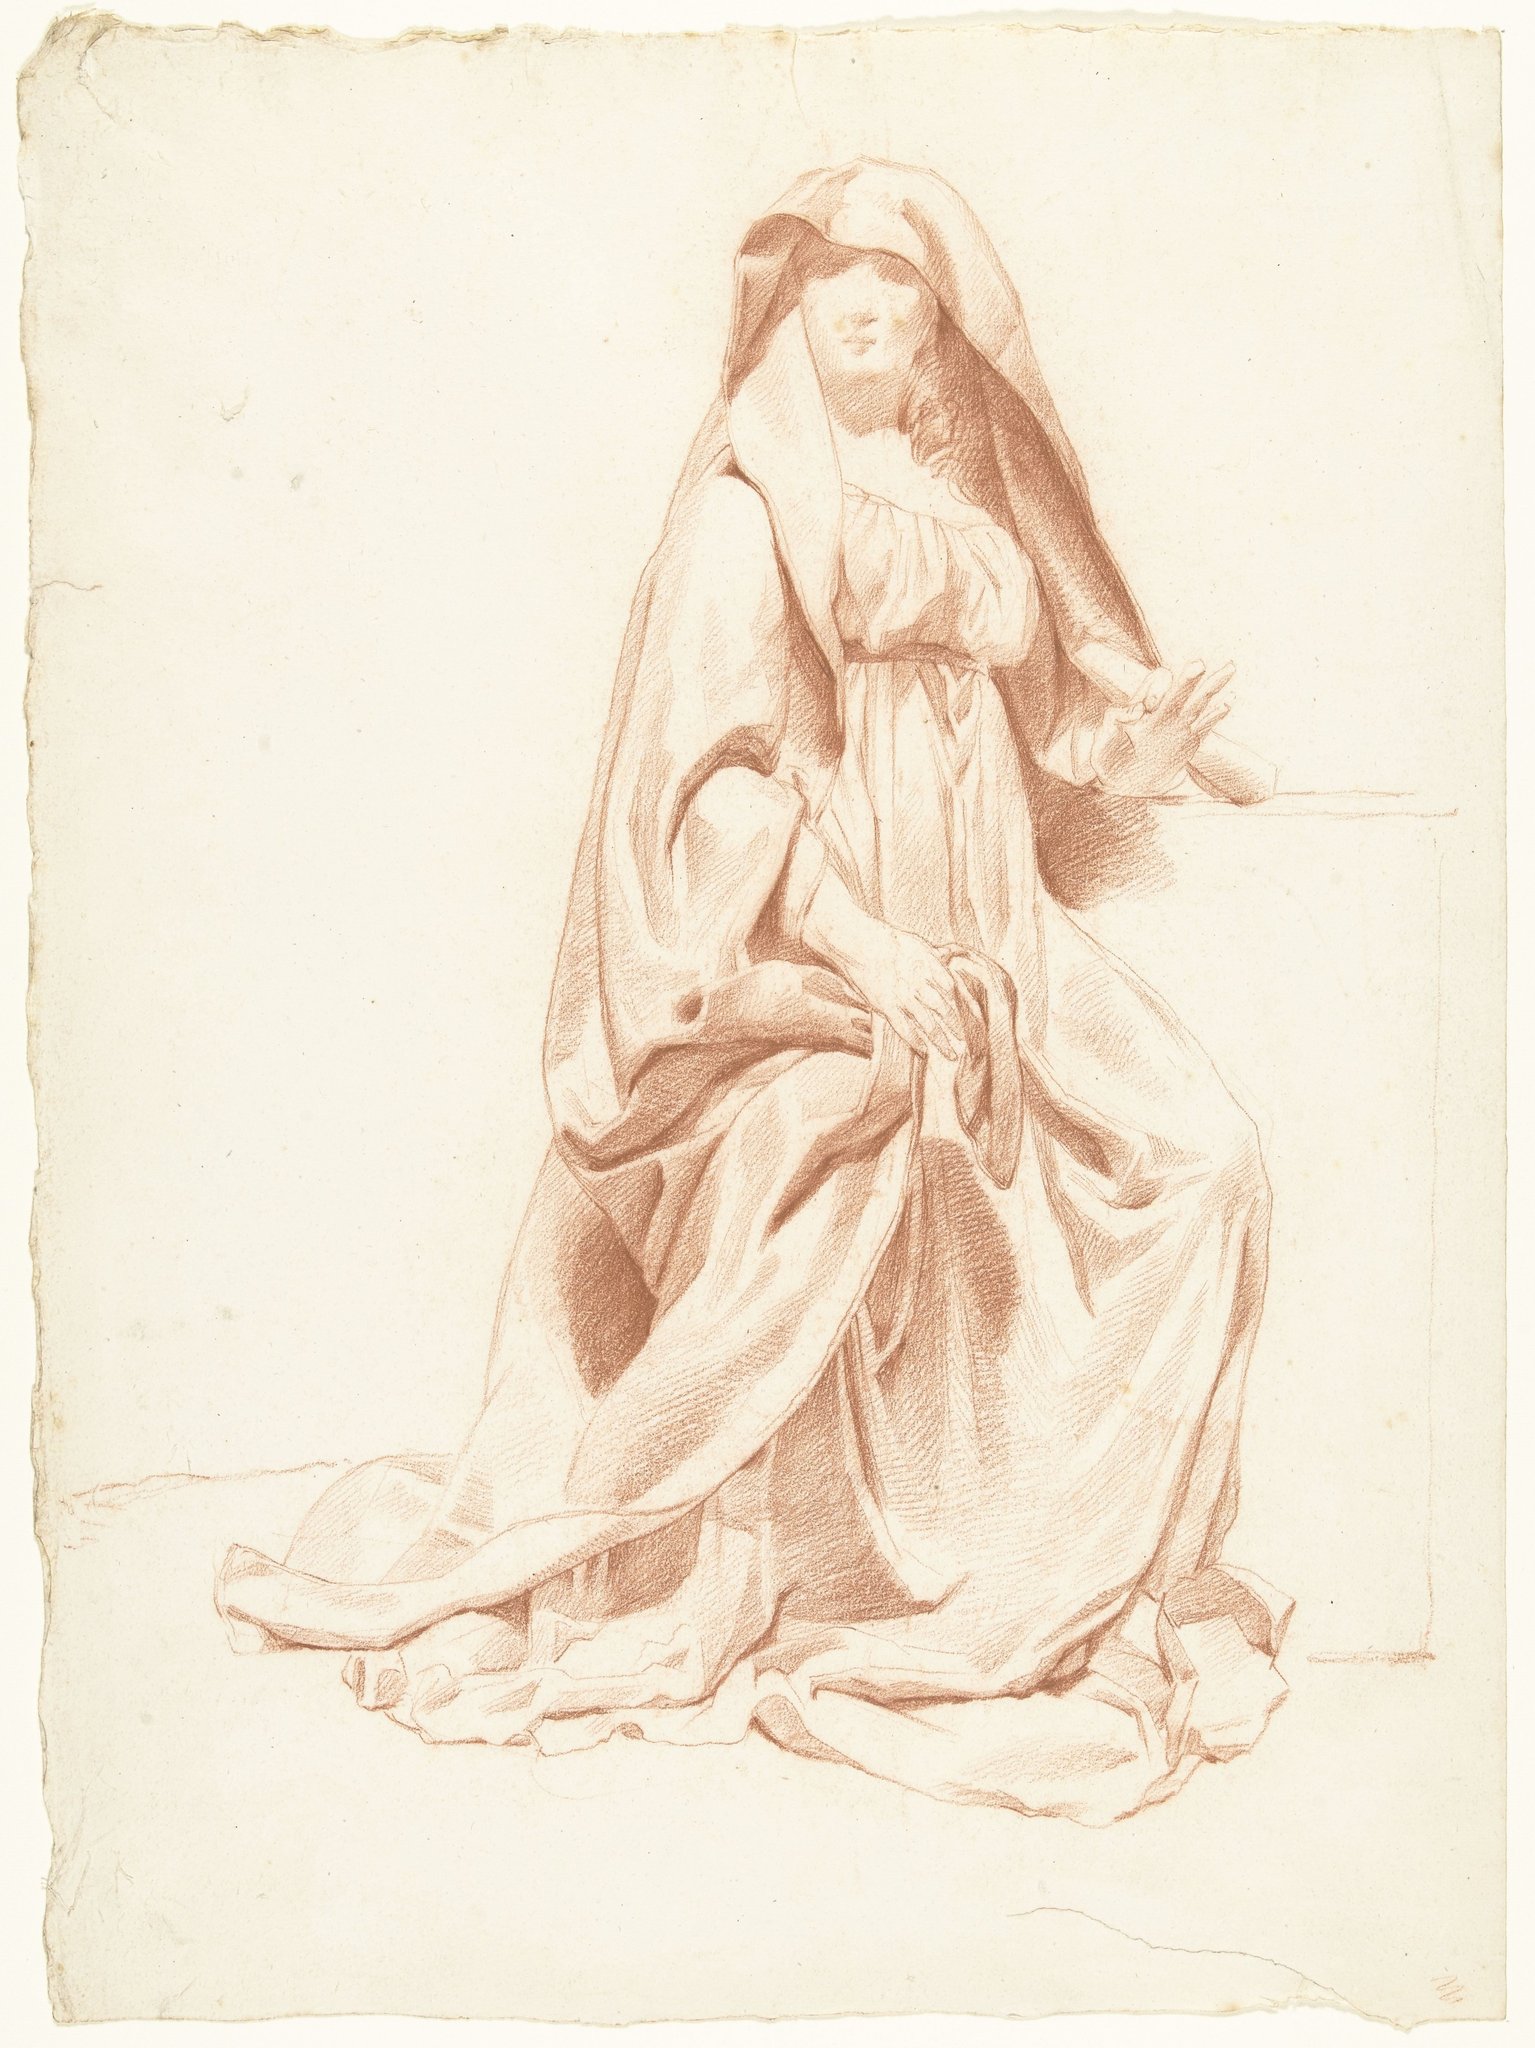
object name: drawing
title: Studie van een zittende vrouw met zwaar geplooide mantel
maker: Anonymous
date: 1700-1800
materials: chalk, paper